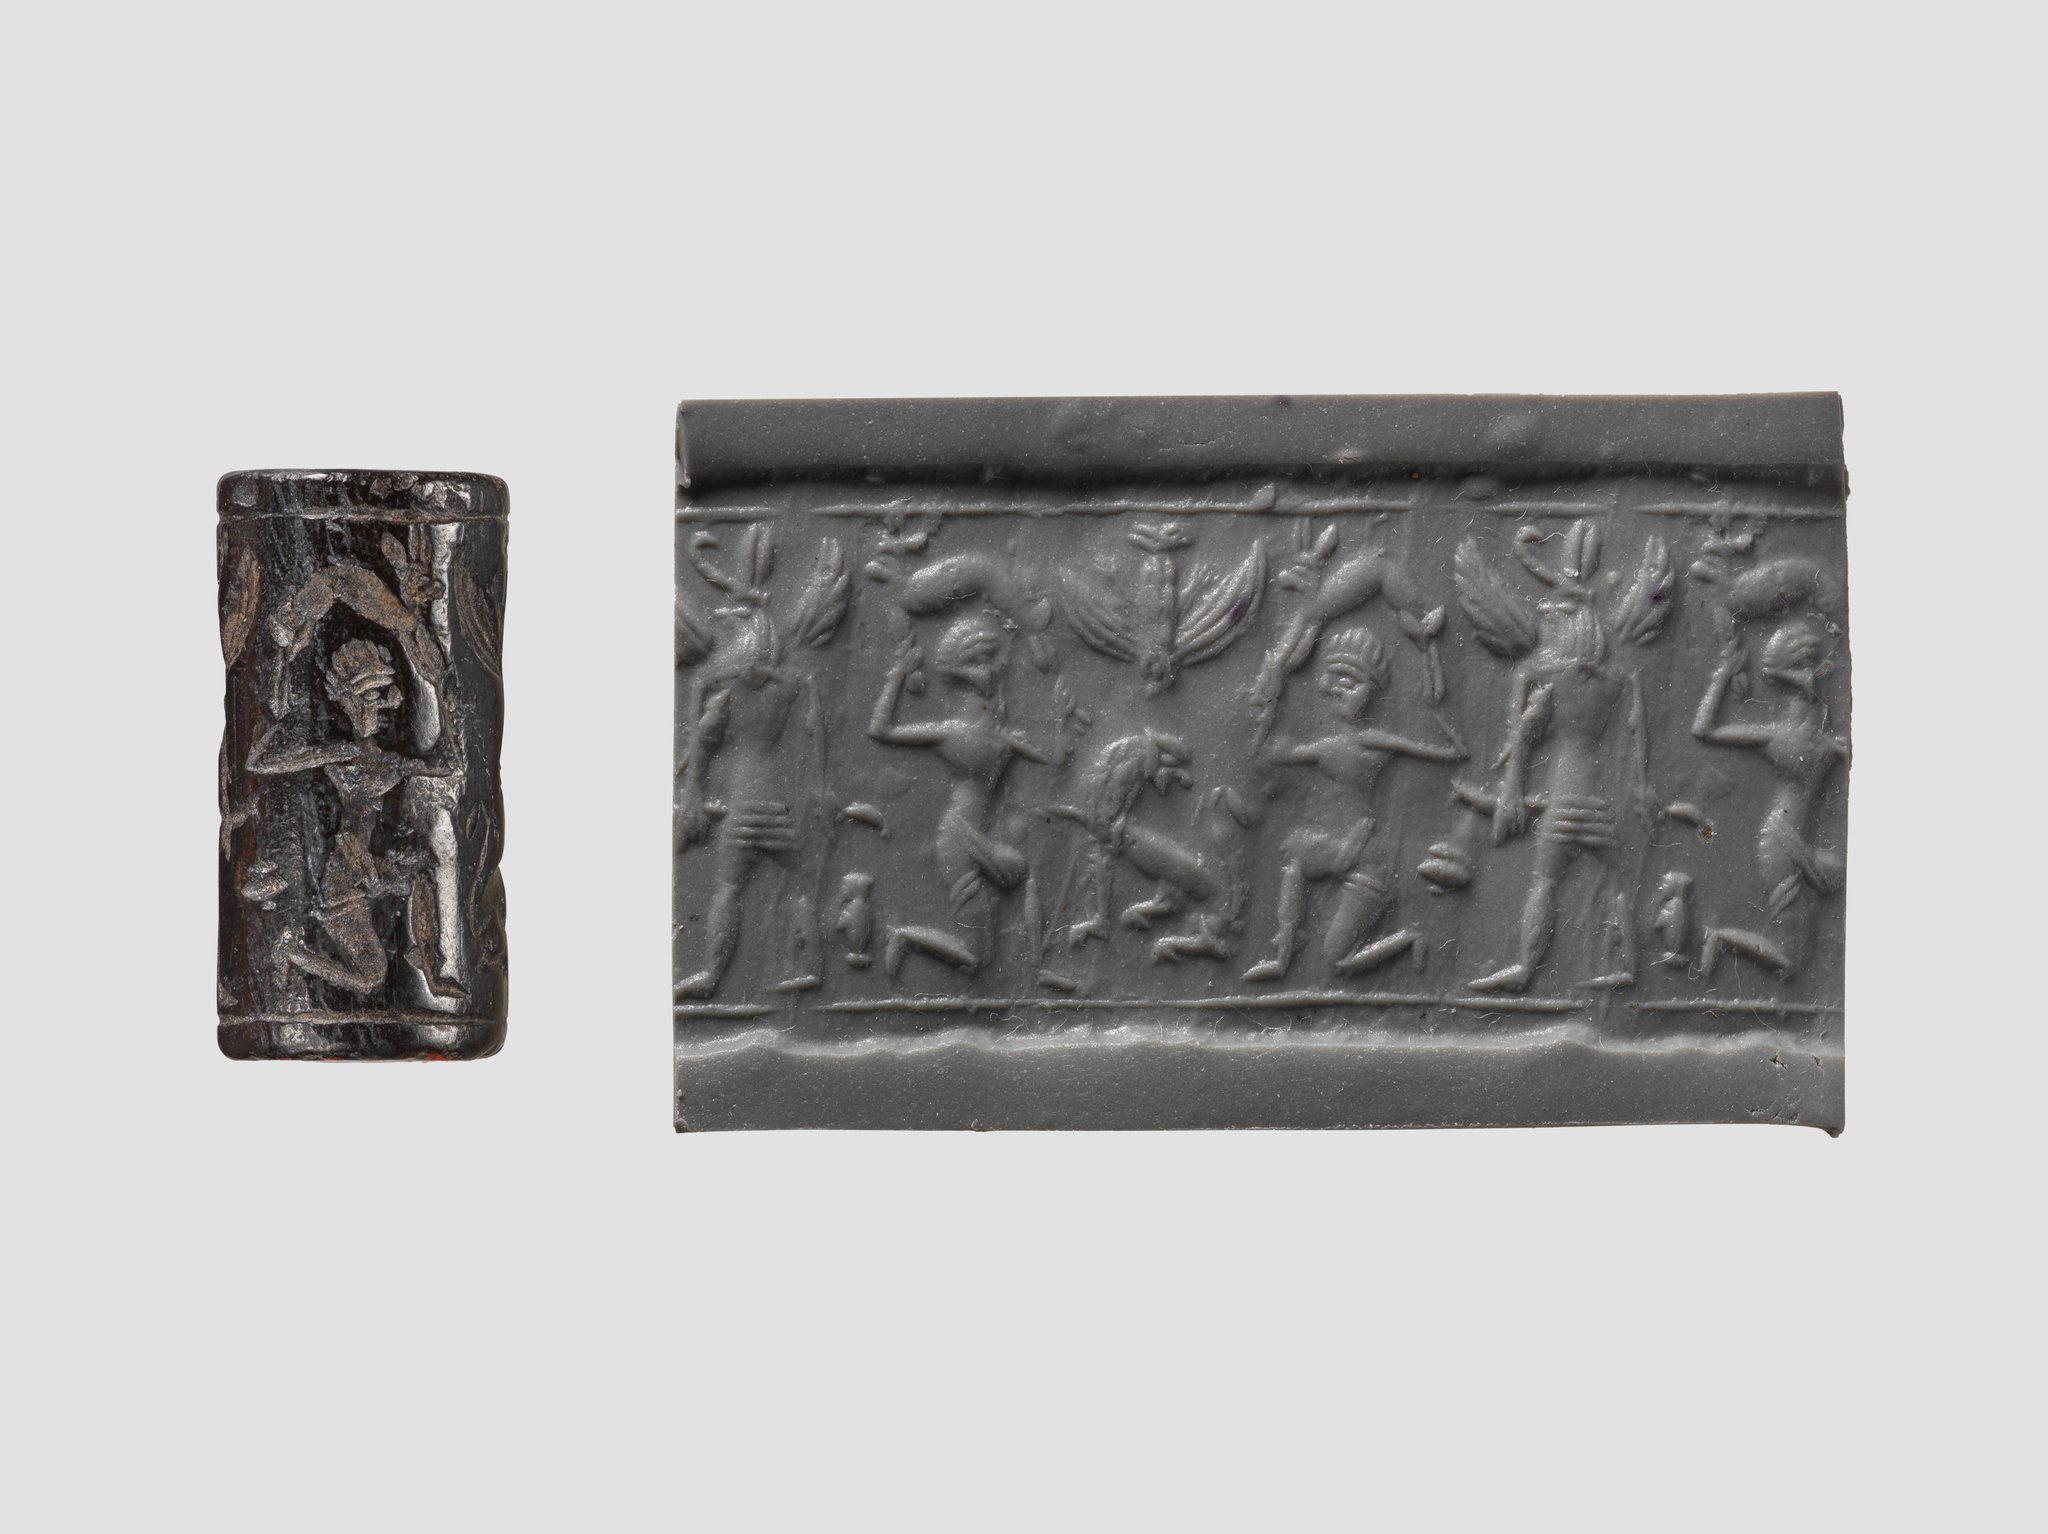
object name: cylinder seal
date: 1820-1730 BCE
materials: mineral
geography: syria